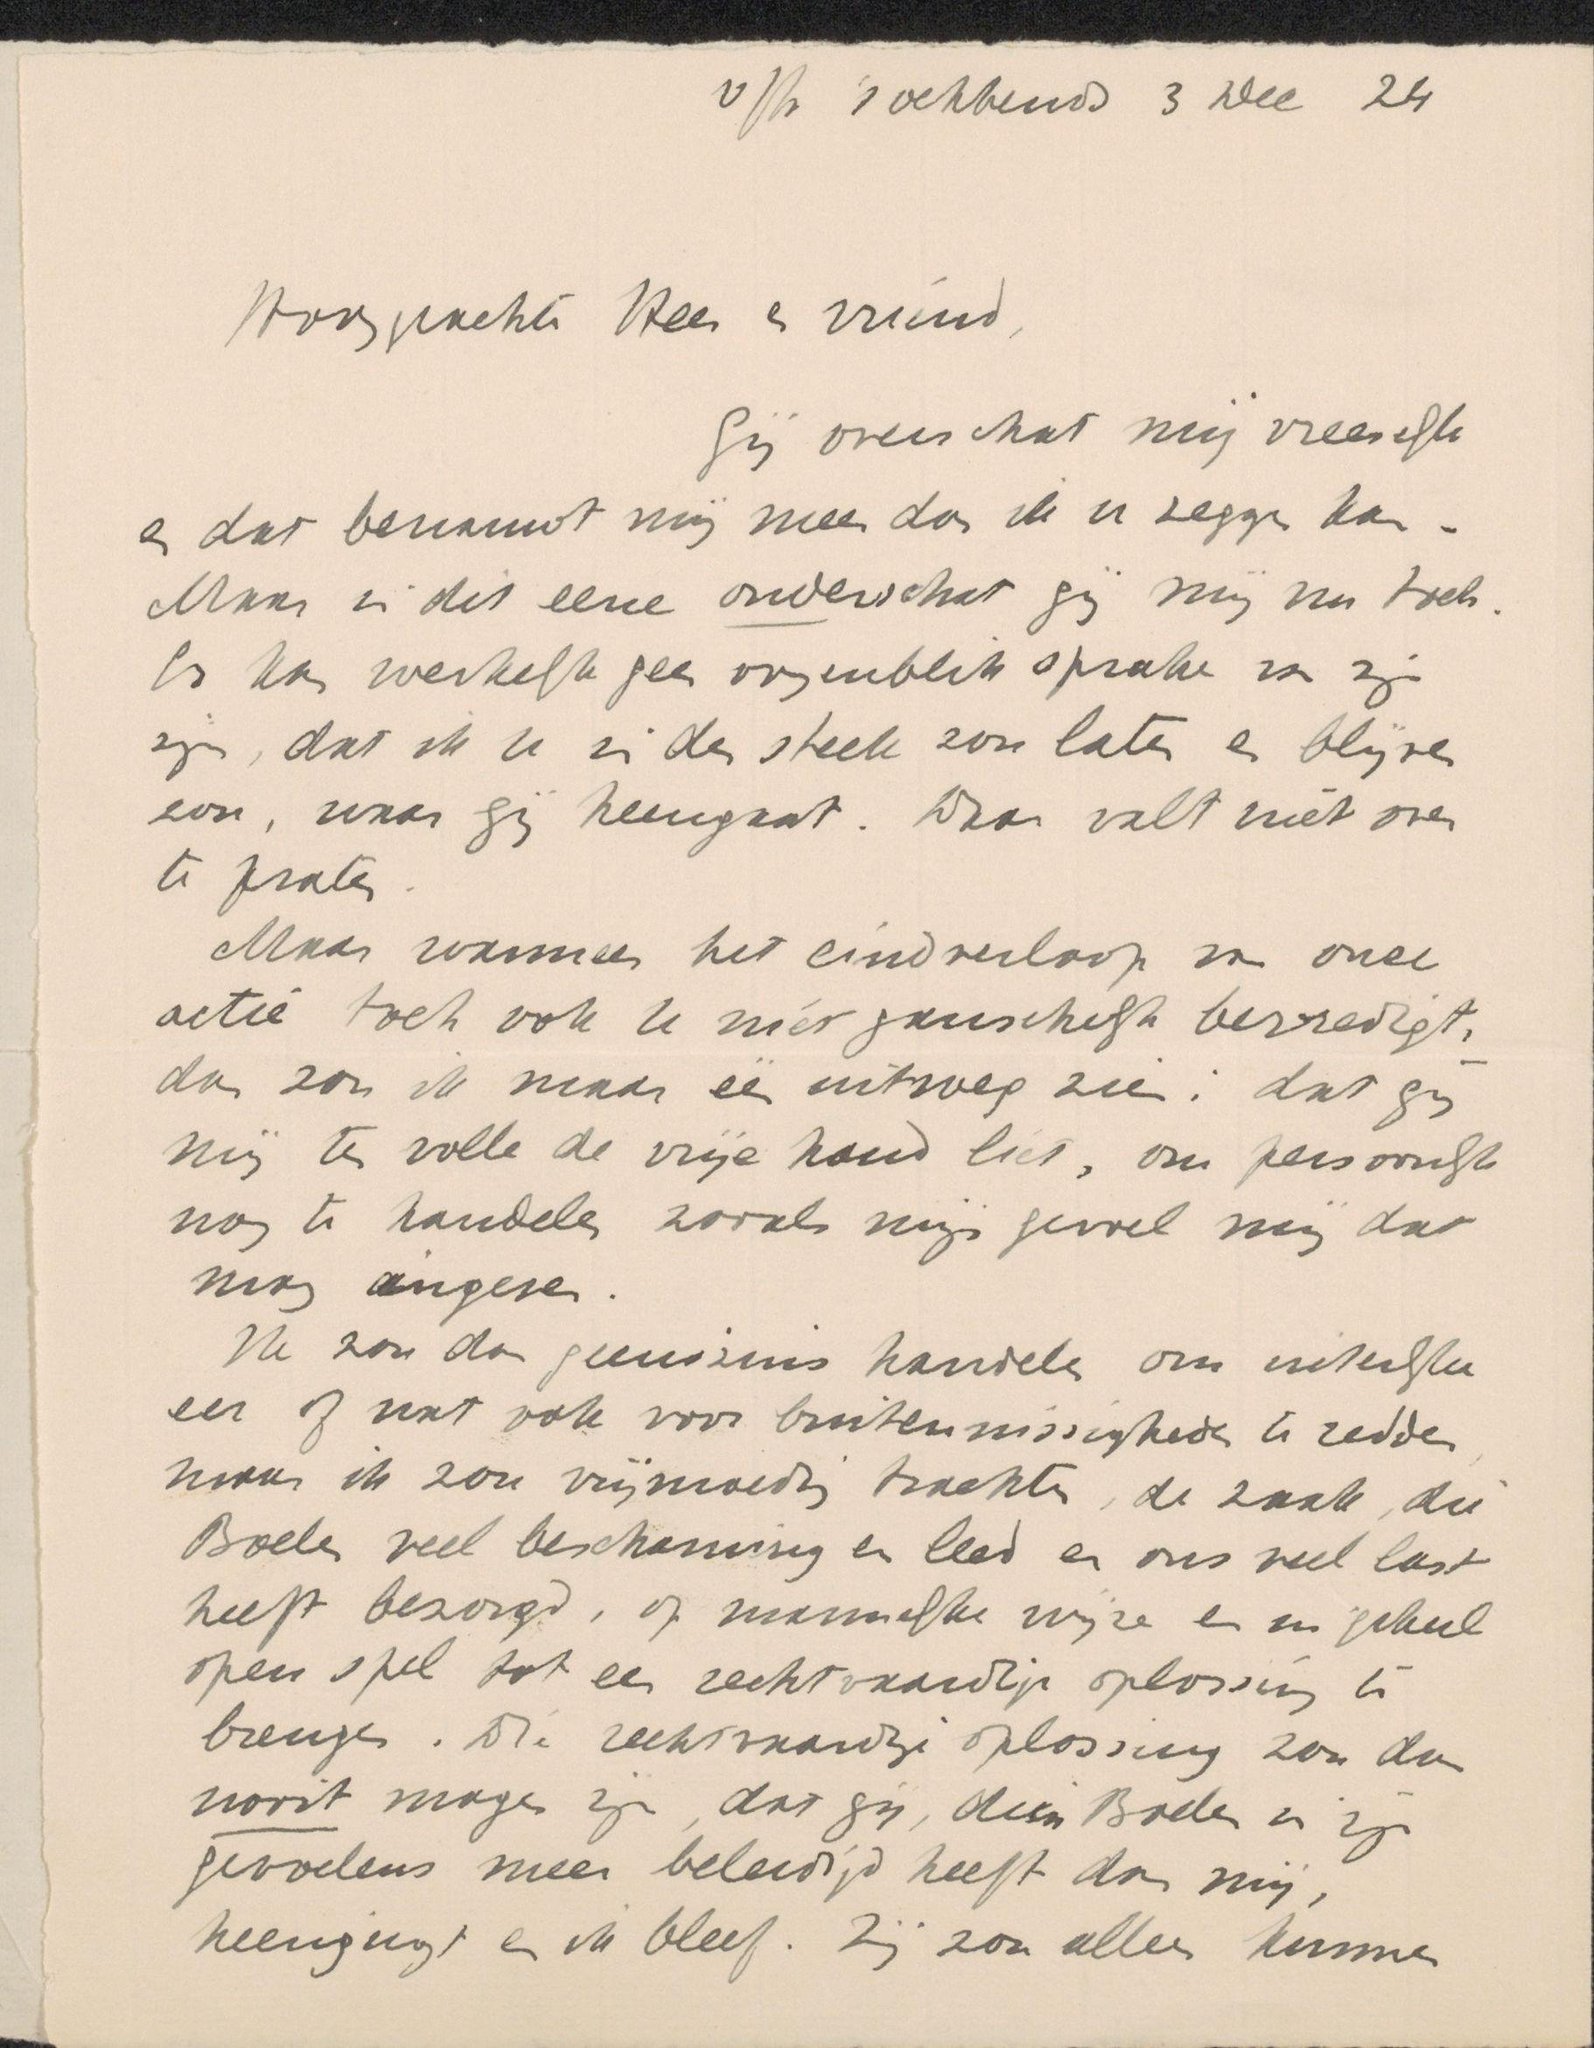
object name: letter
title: Brief aan F.E. Posthumus Meyjes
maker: jan veth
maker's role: designer, draughtsman, painter, print maker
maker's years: 1864-1925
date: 1924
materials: ink, paper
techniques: pen, writing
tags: f.e. posthumus meyjes, passions, emotions, affections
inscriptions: collector's mark: ‘RPK’